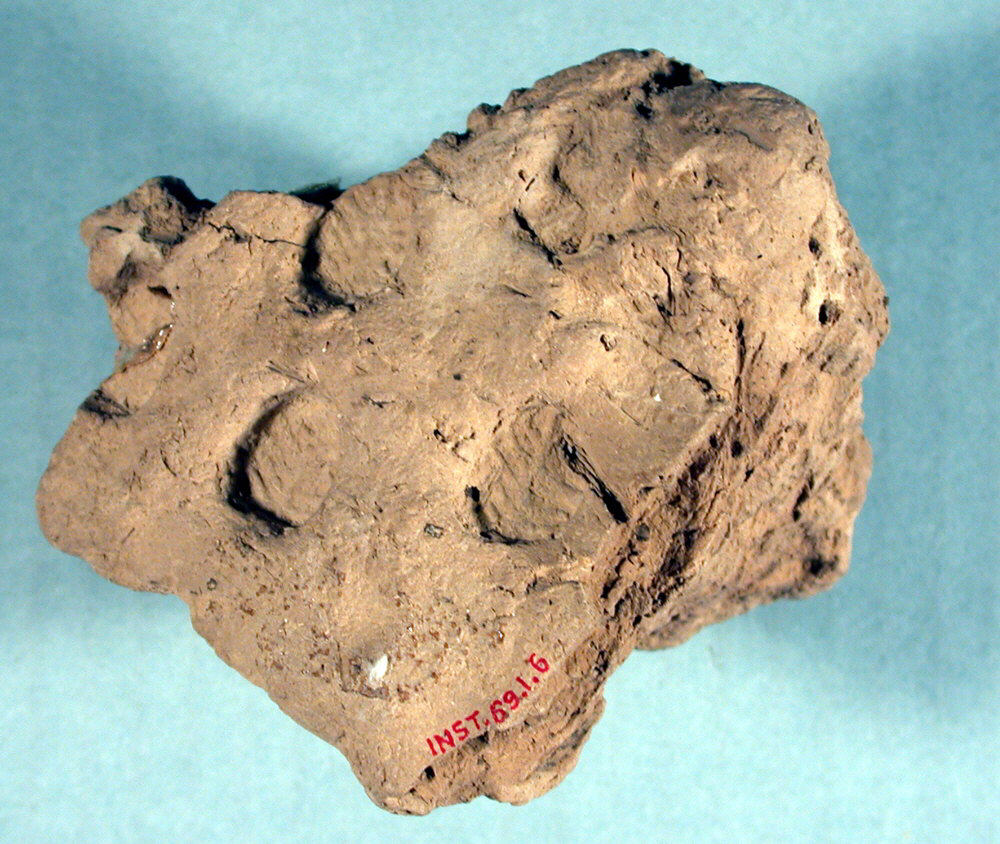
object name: sealing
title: Sealing on jar stopper (?)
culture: parthian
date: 1-100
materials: ceramic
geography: iran